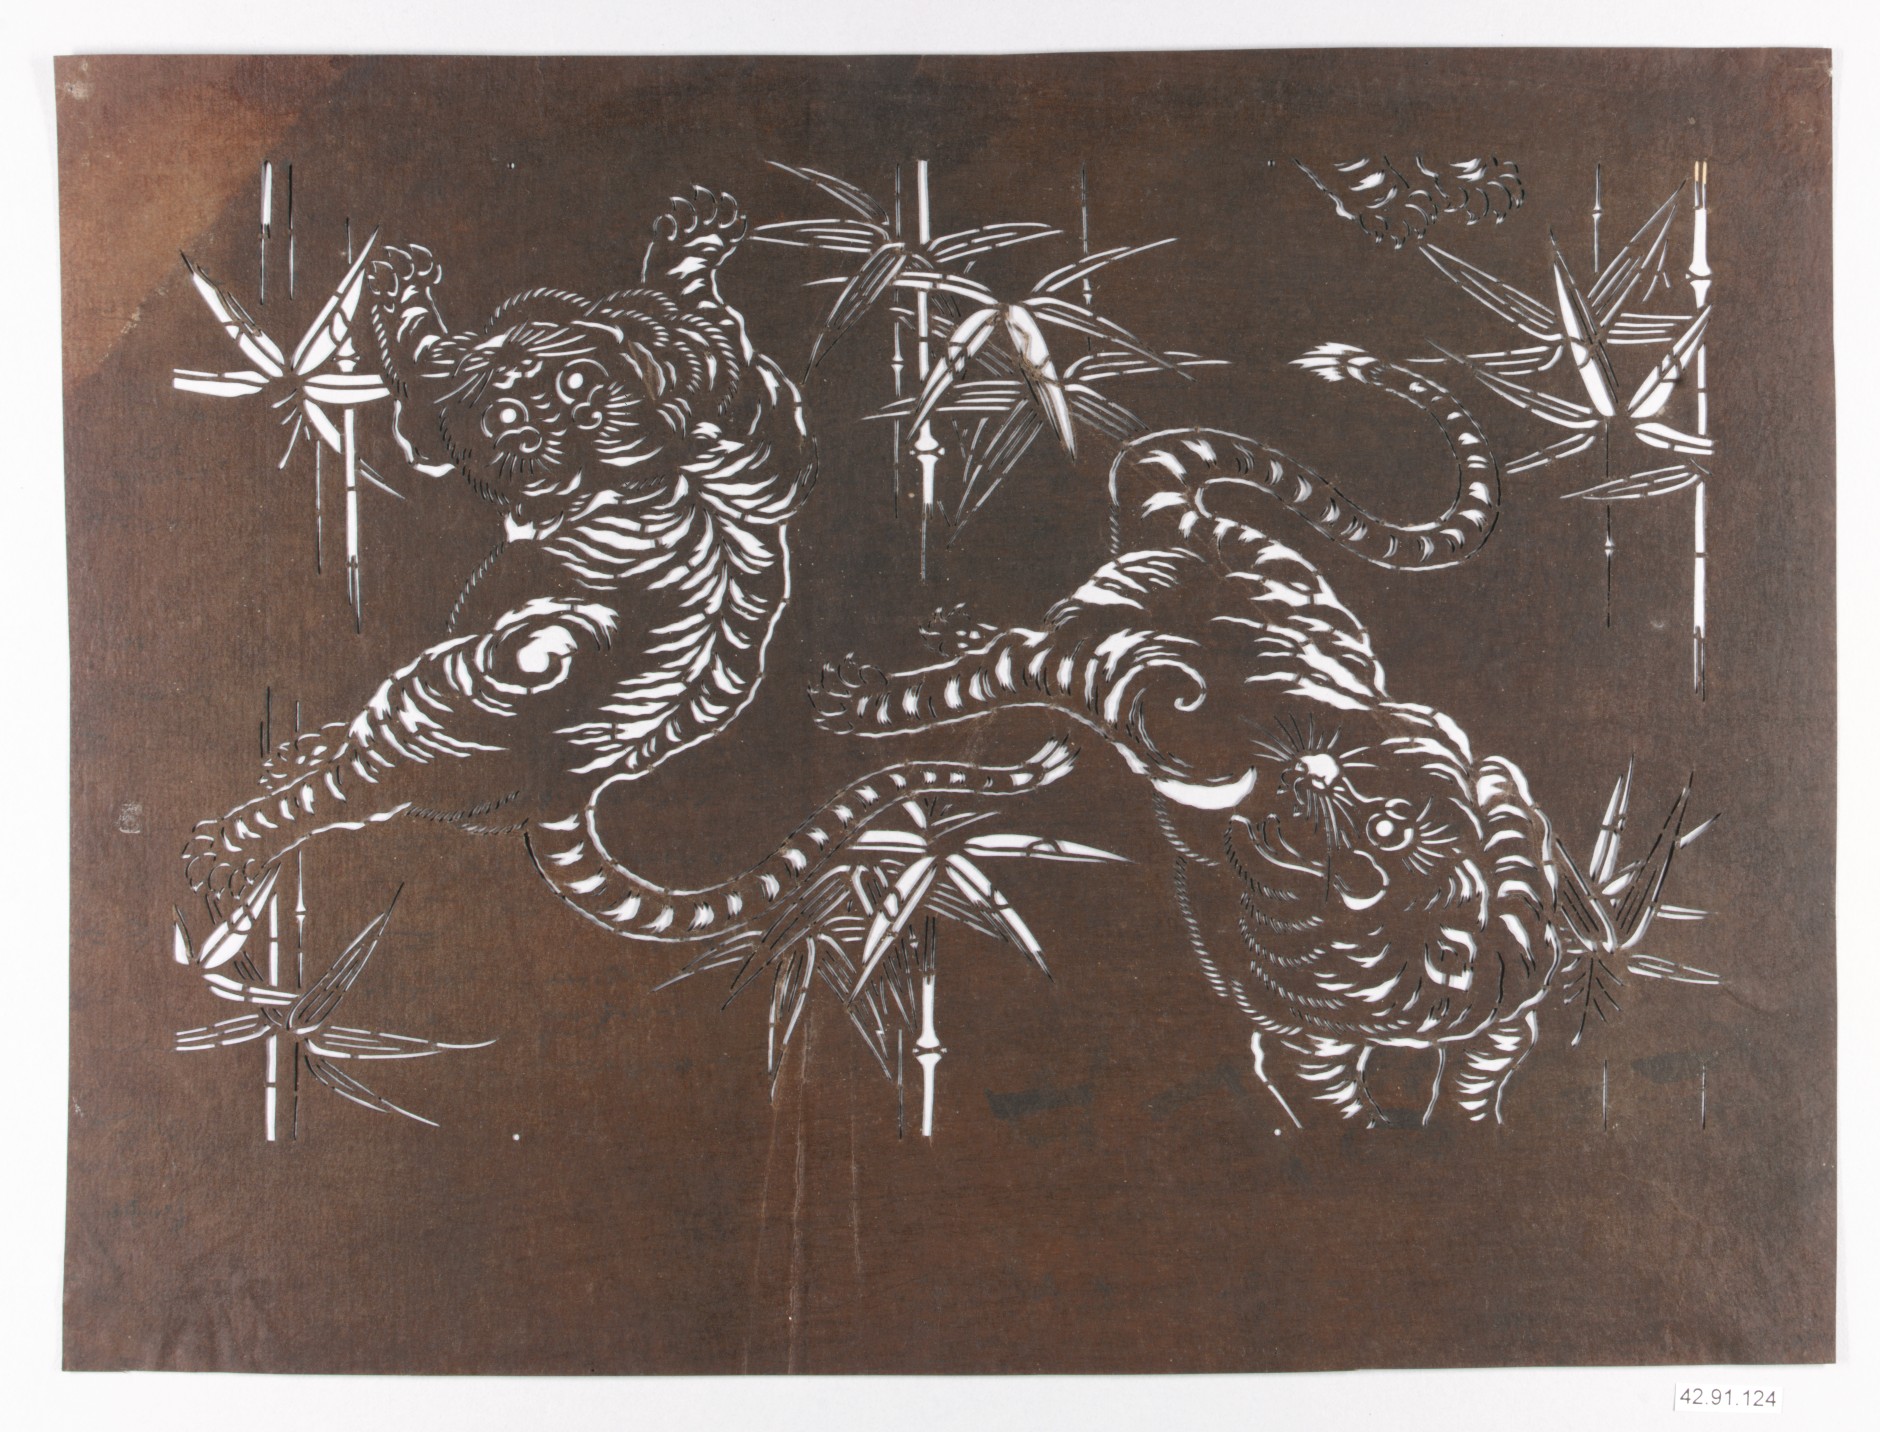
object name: stencil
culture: japanese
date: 1801-1900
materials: paper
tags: tigers